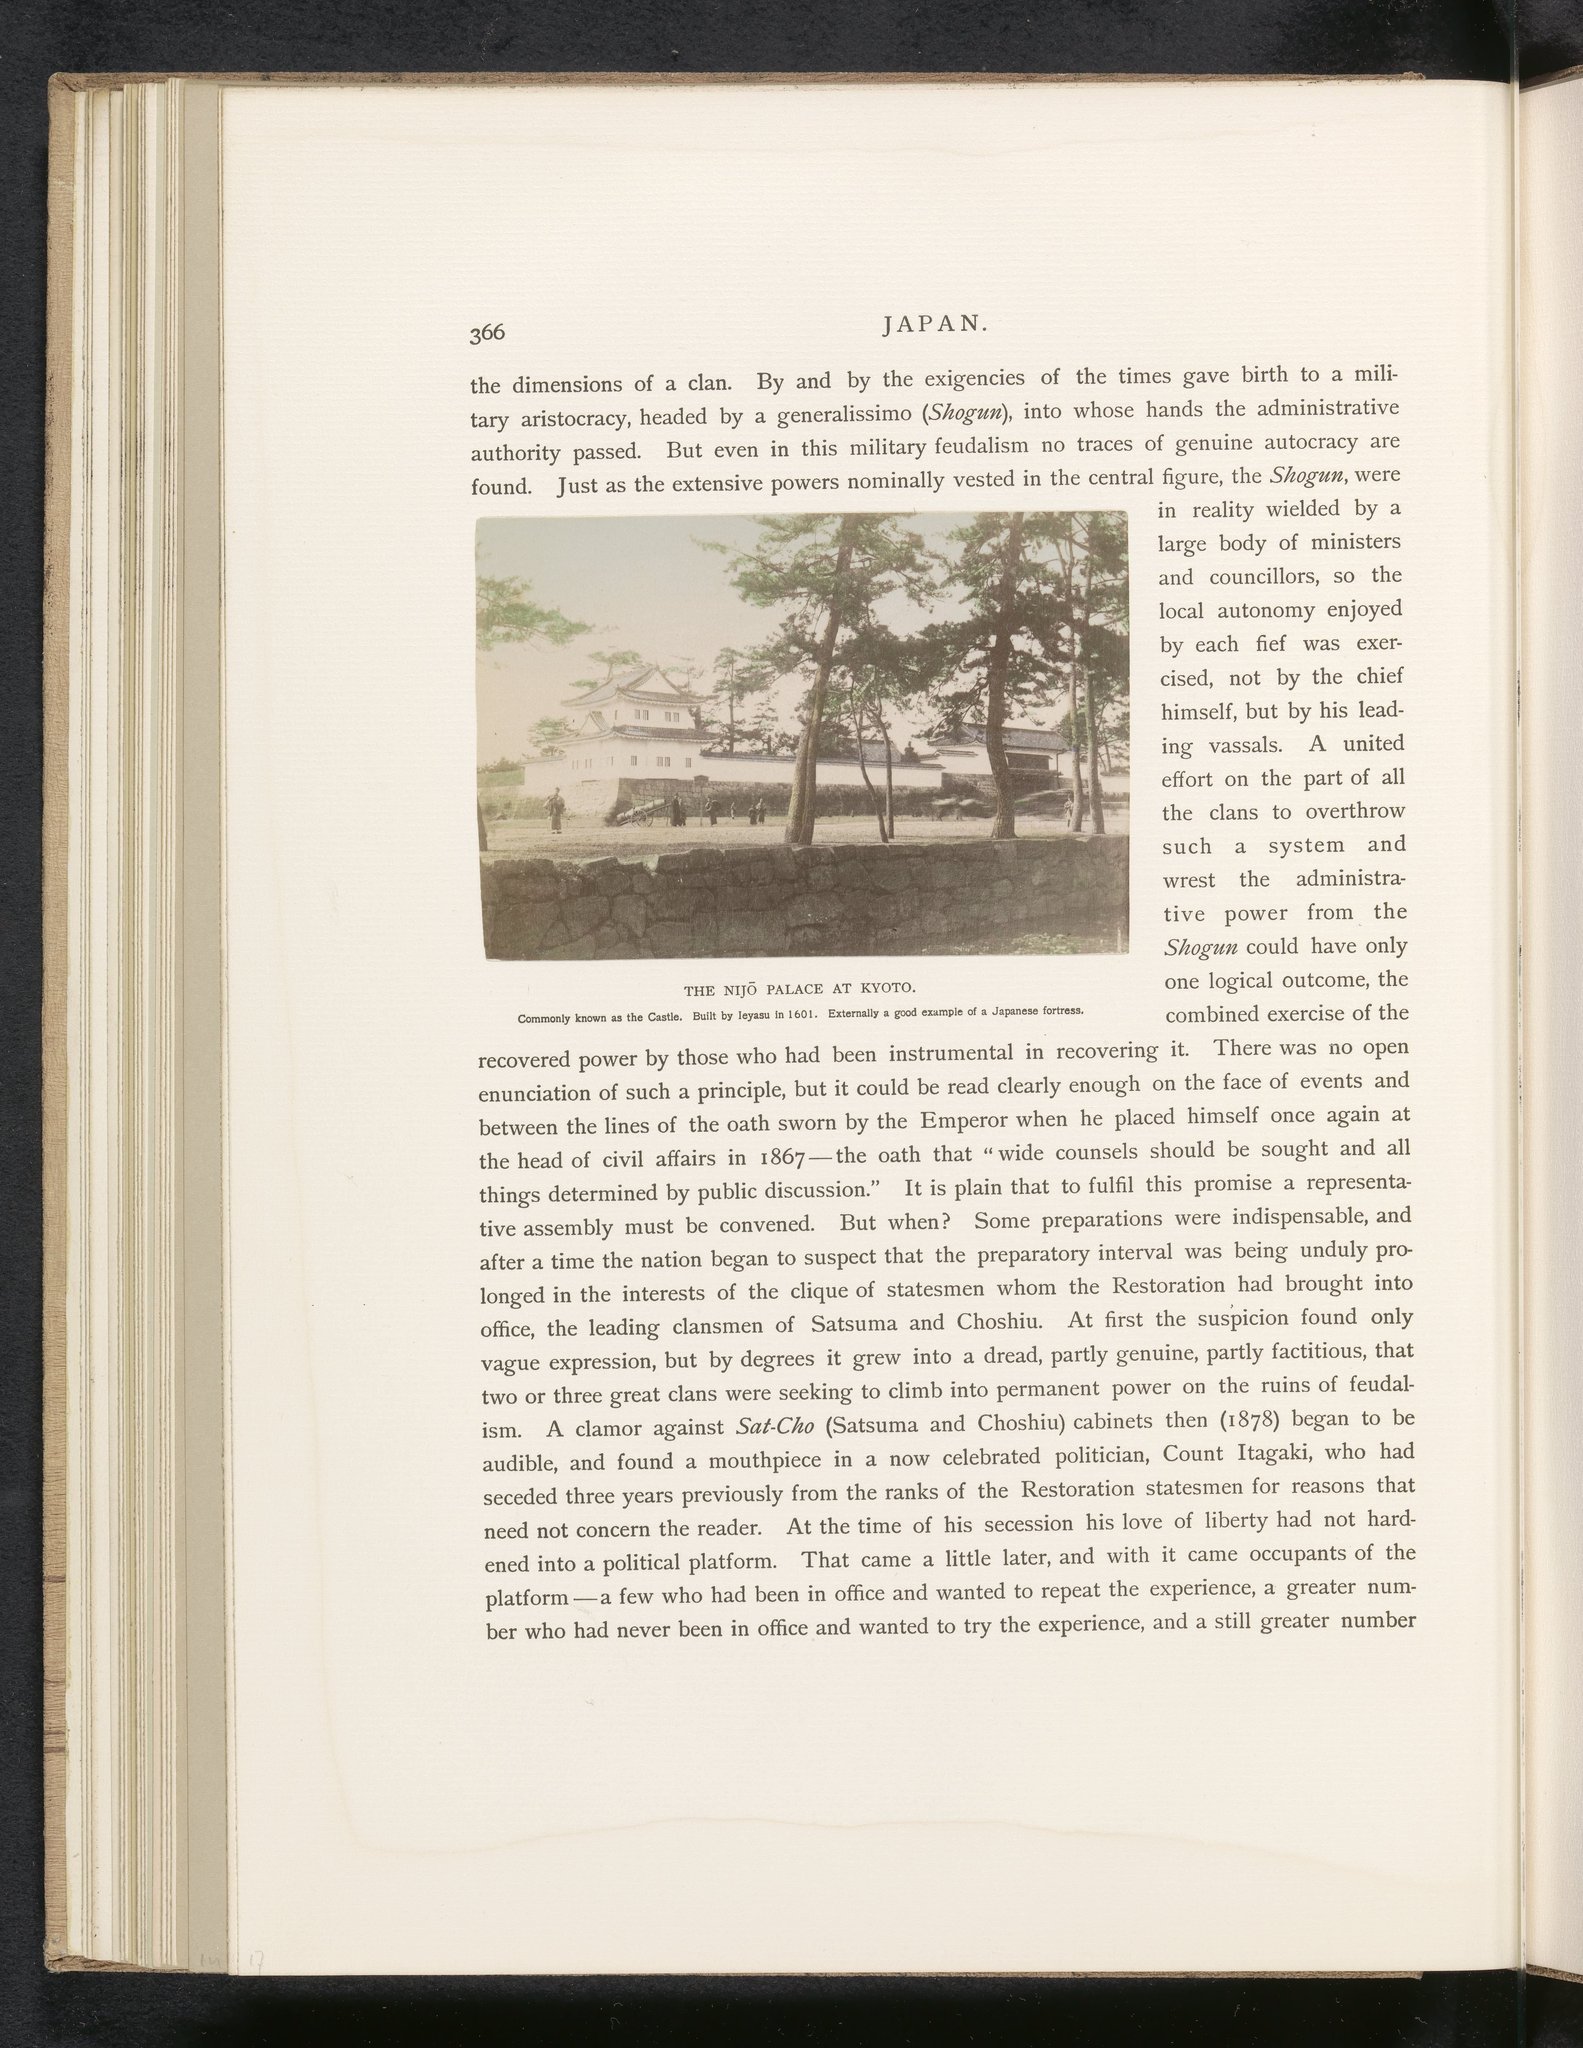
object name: photograph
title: The Nijō palace at Kyoto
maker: Anonymous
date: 1888-1898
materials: photographic support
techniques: albumen print, hand coloring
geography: japan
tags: palace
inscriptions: inscription: ‘Commonly known as the Castle. Built by Ieyasu in 1601. Externally a good example of a Japanese fortress.’